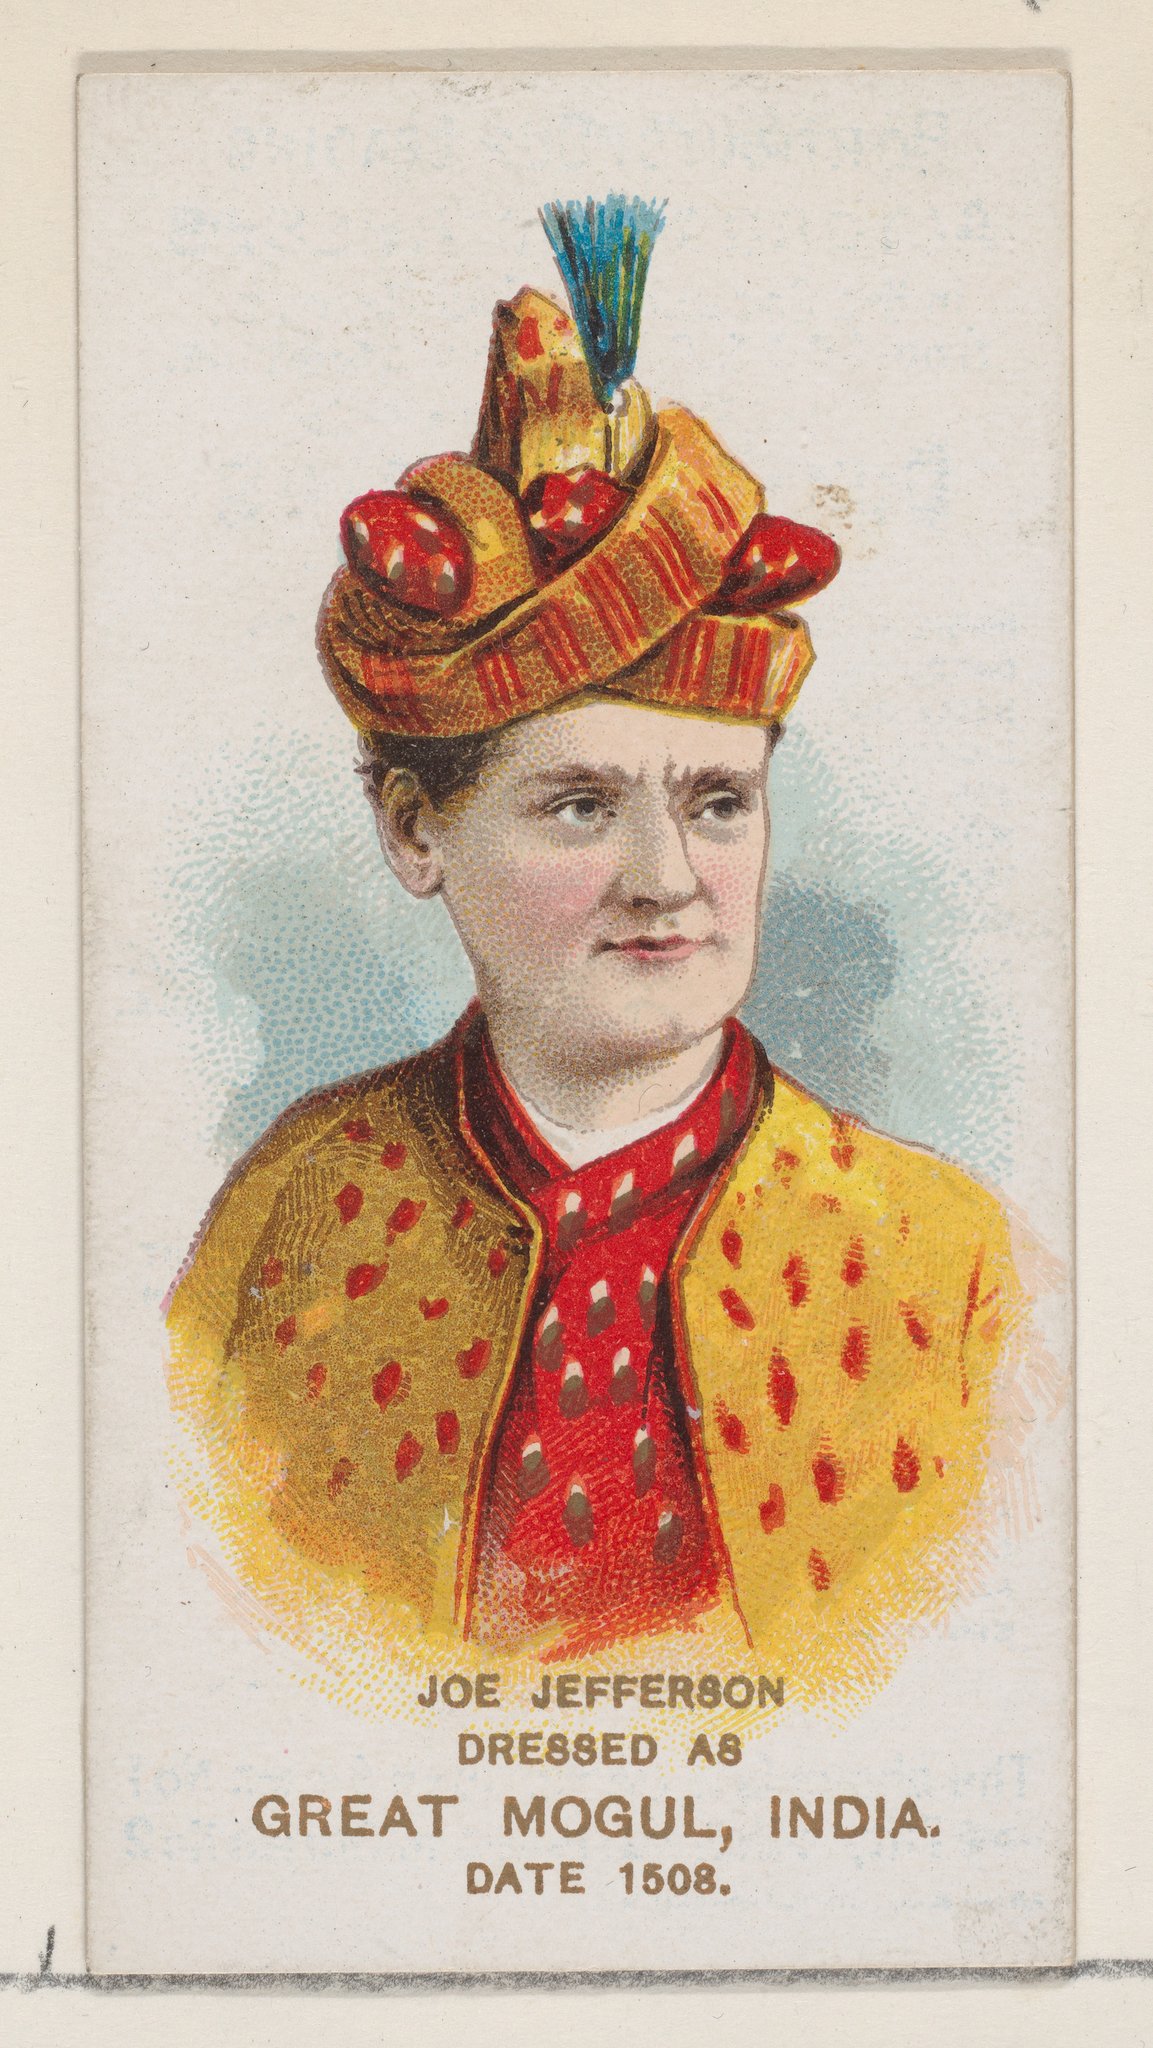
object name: print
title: Joe Jefferson Dressed as a Great Mogul, India, in 1508, from the set Actors and Actresses, First Series (N70) for Duke brand cigarettes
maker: w. duke, sons & co.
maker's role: publisher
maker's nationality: american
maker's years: 1870-1920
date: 1888-1889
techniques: color lithograph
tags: men,actors